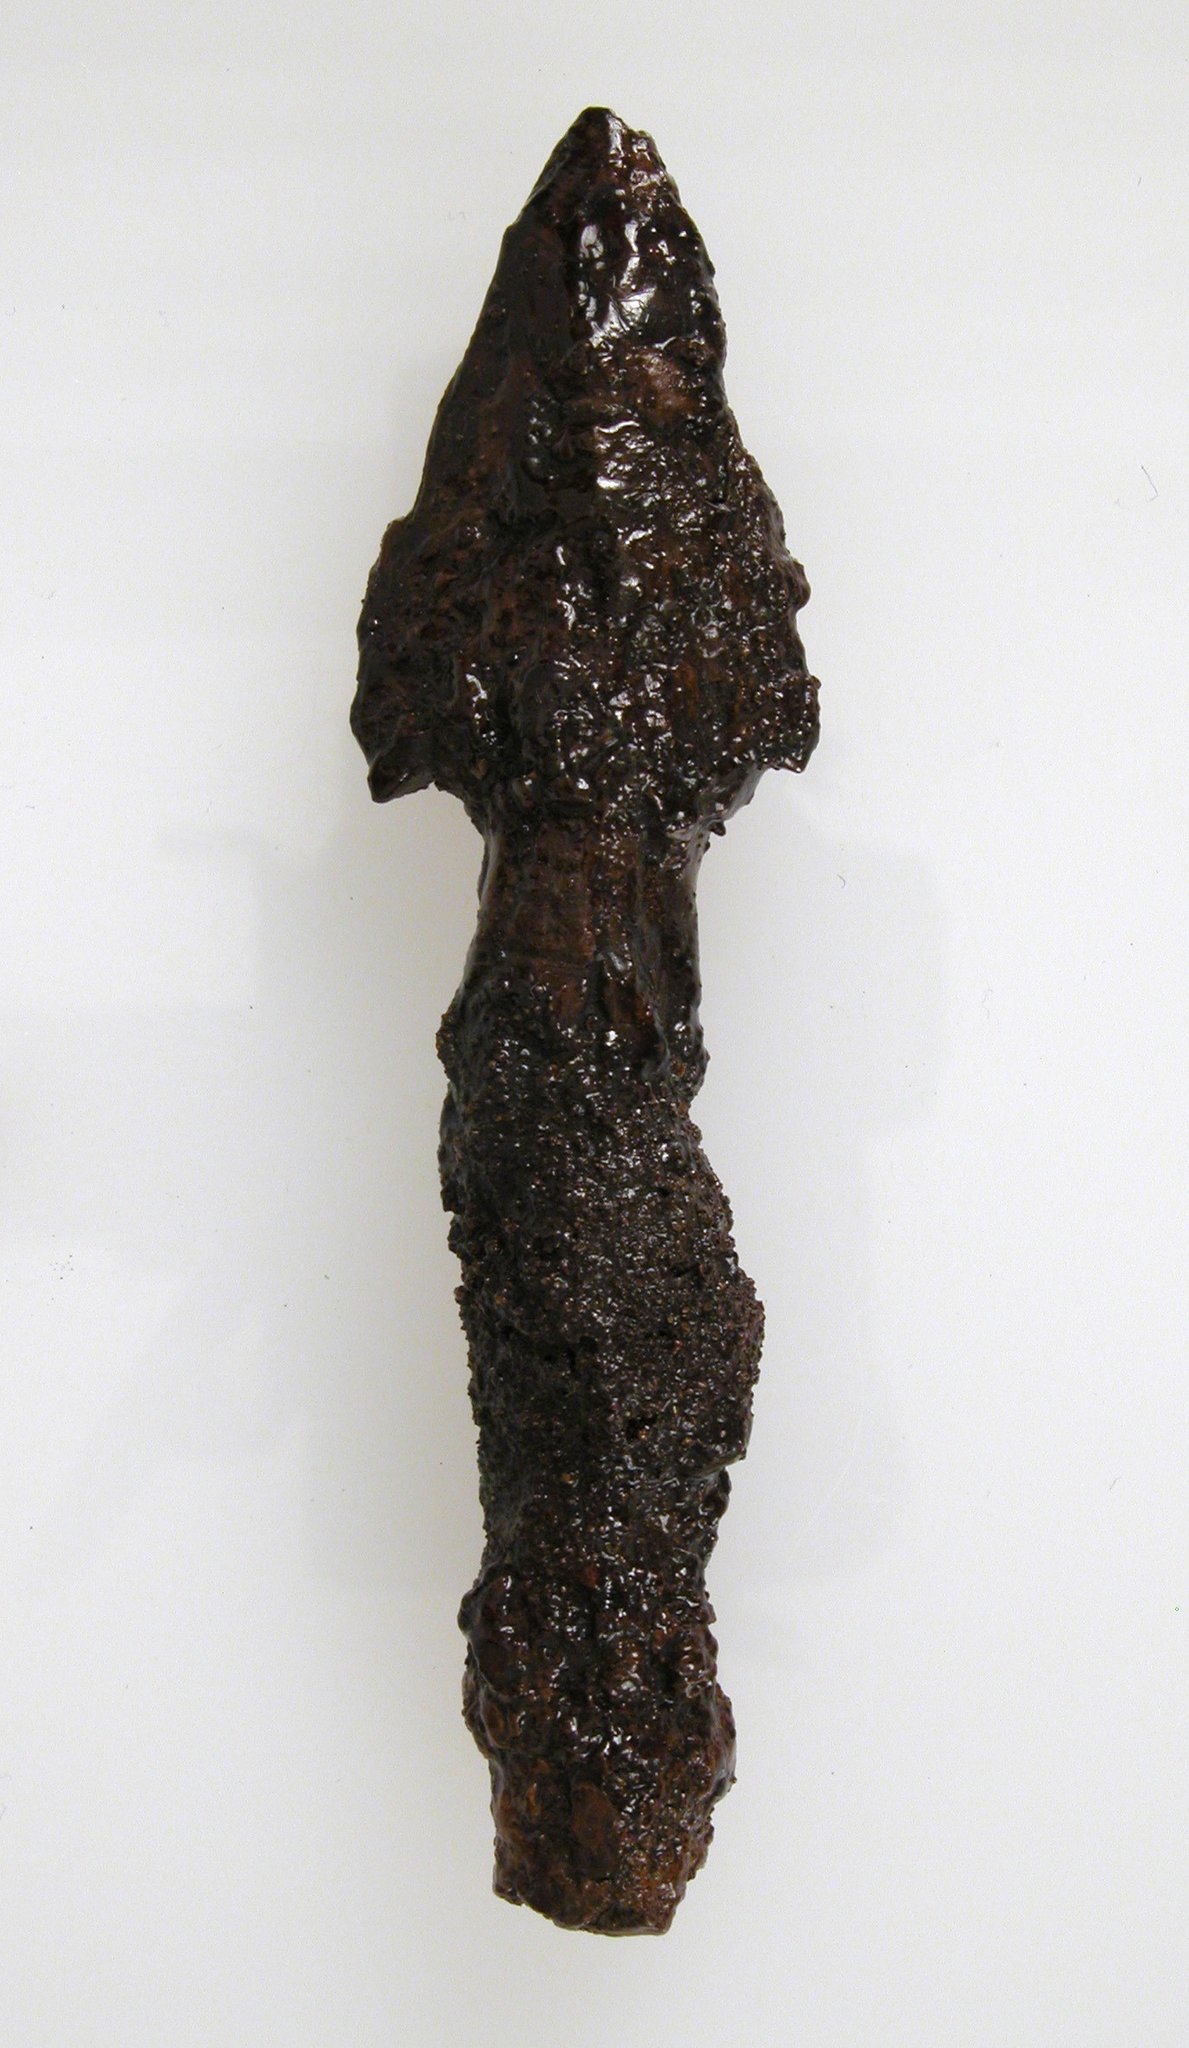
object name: javelin head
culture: frankish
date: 500-600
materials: iron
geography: germany